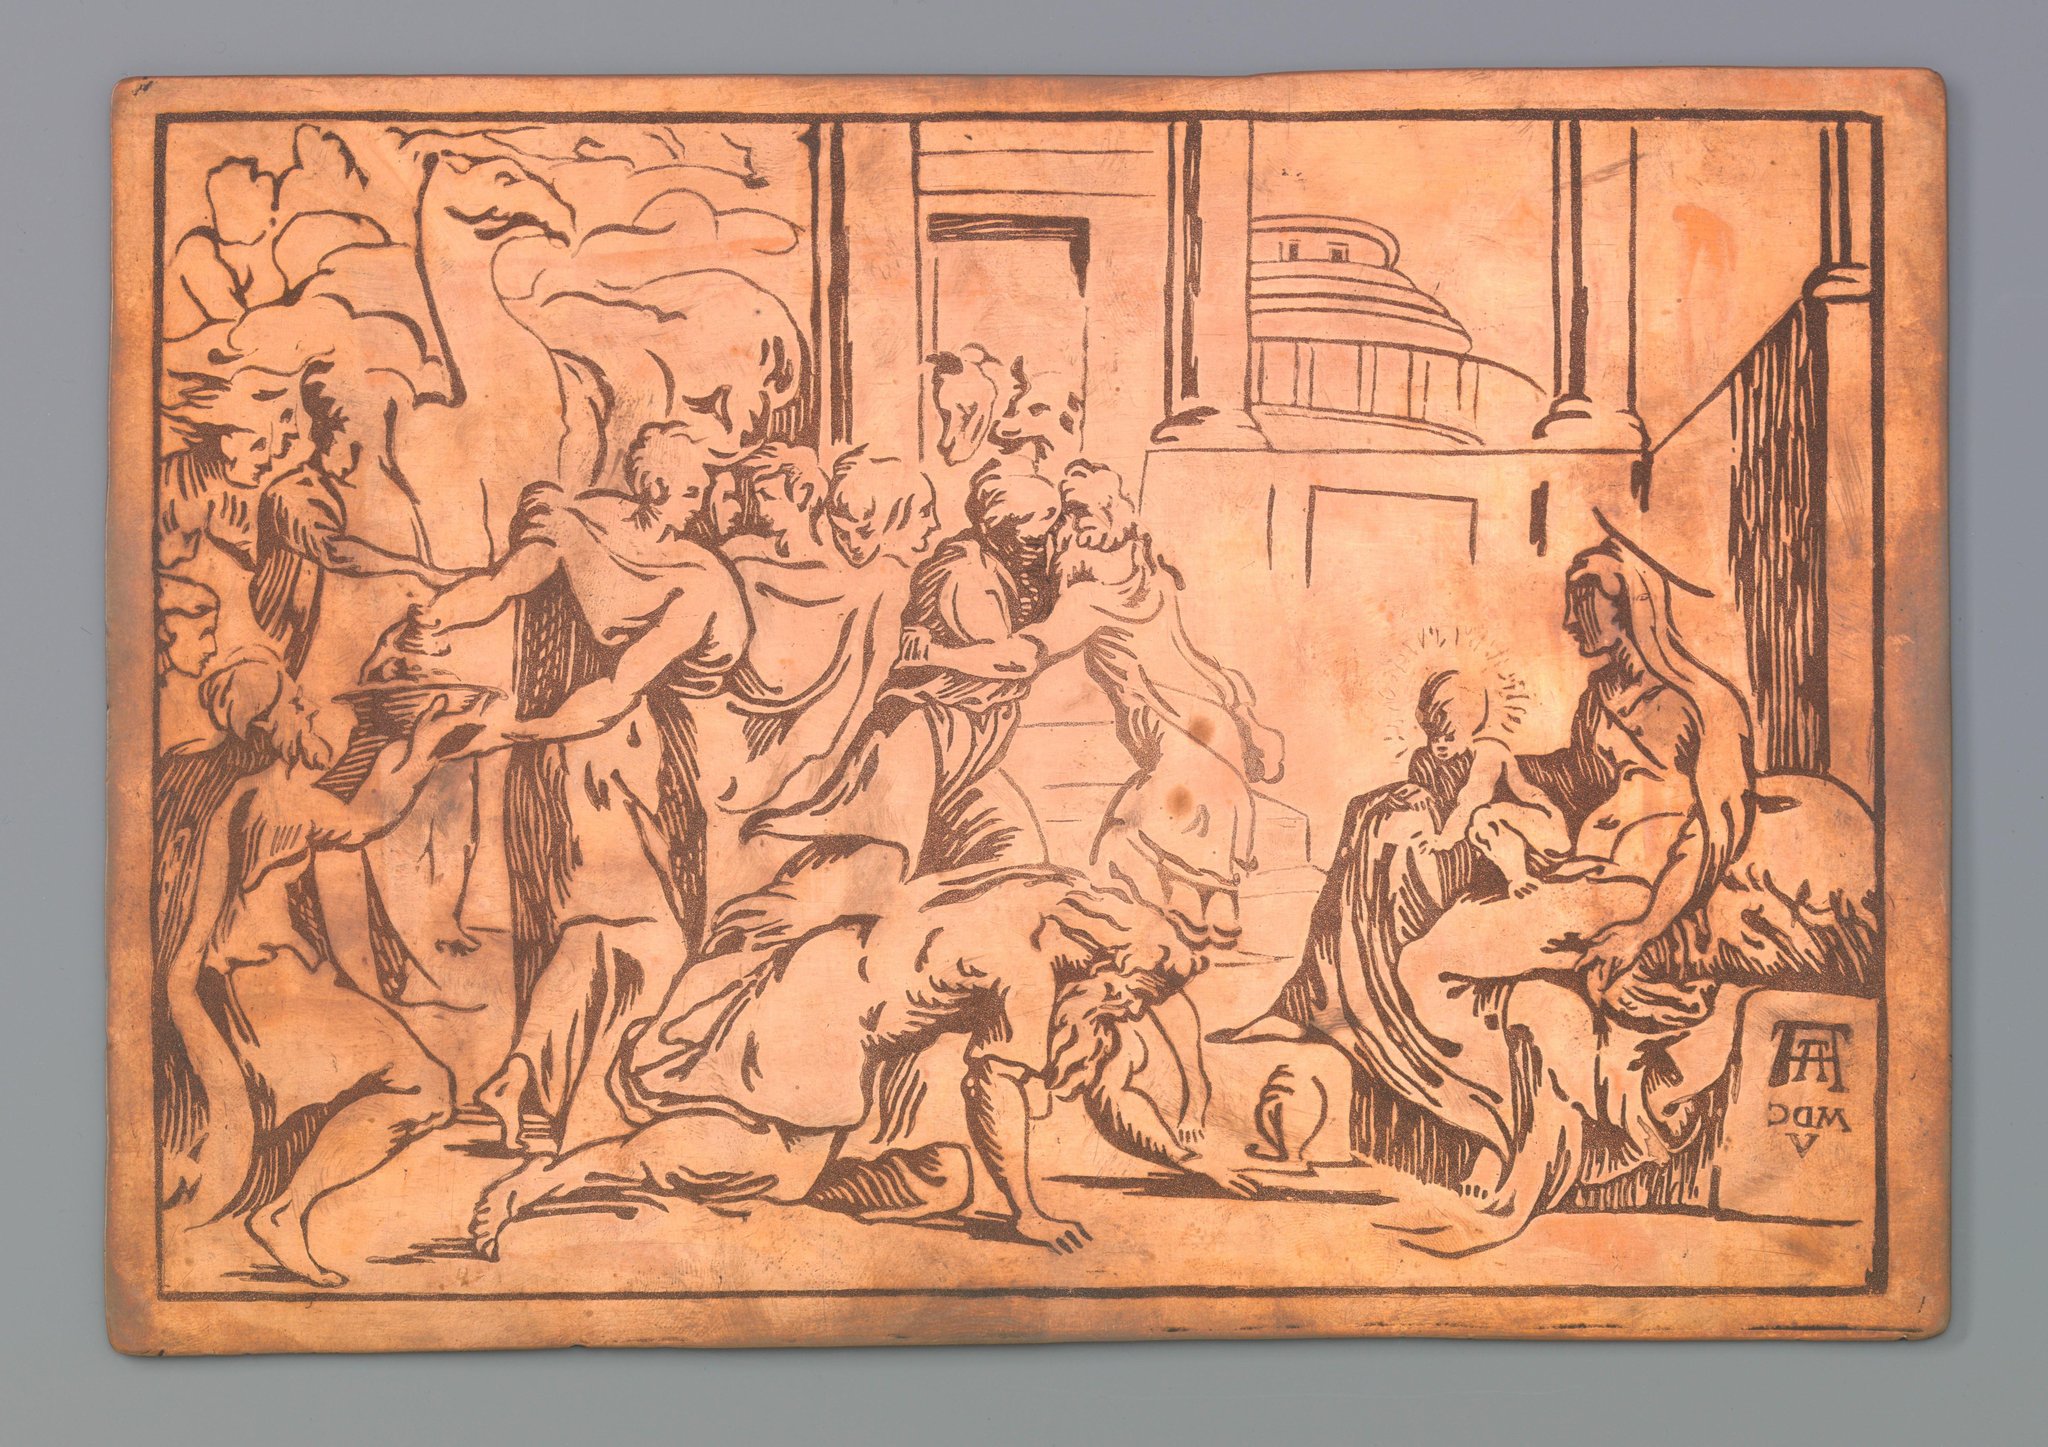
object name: copper plate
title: Aanbidding door de koningen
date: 1605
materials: copper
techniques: etching